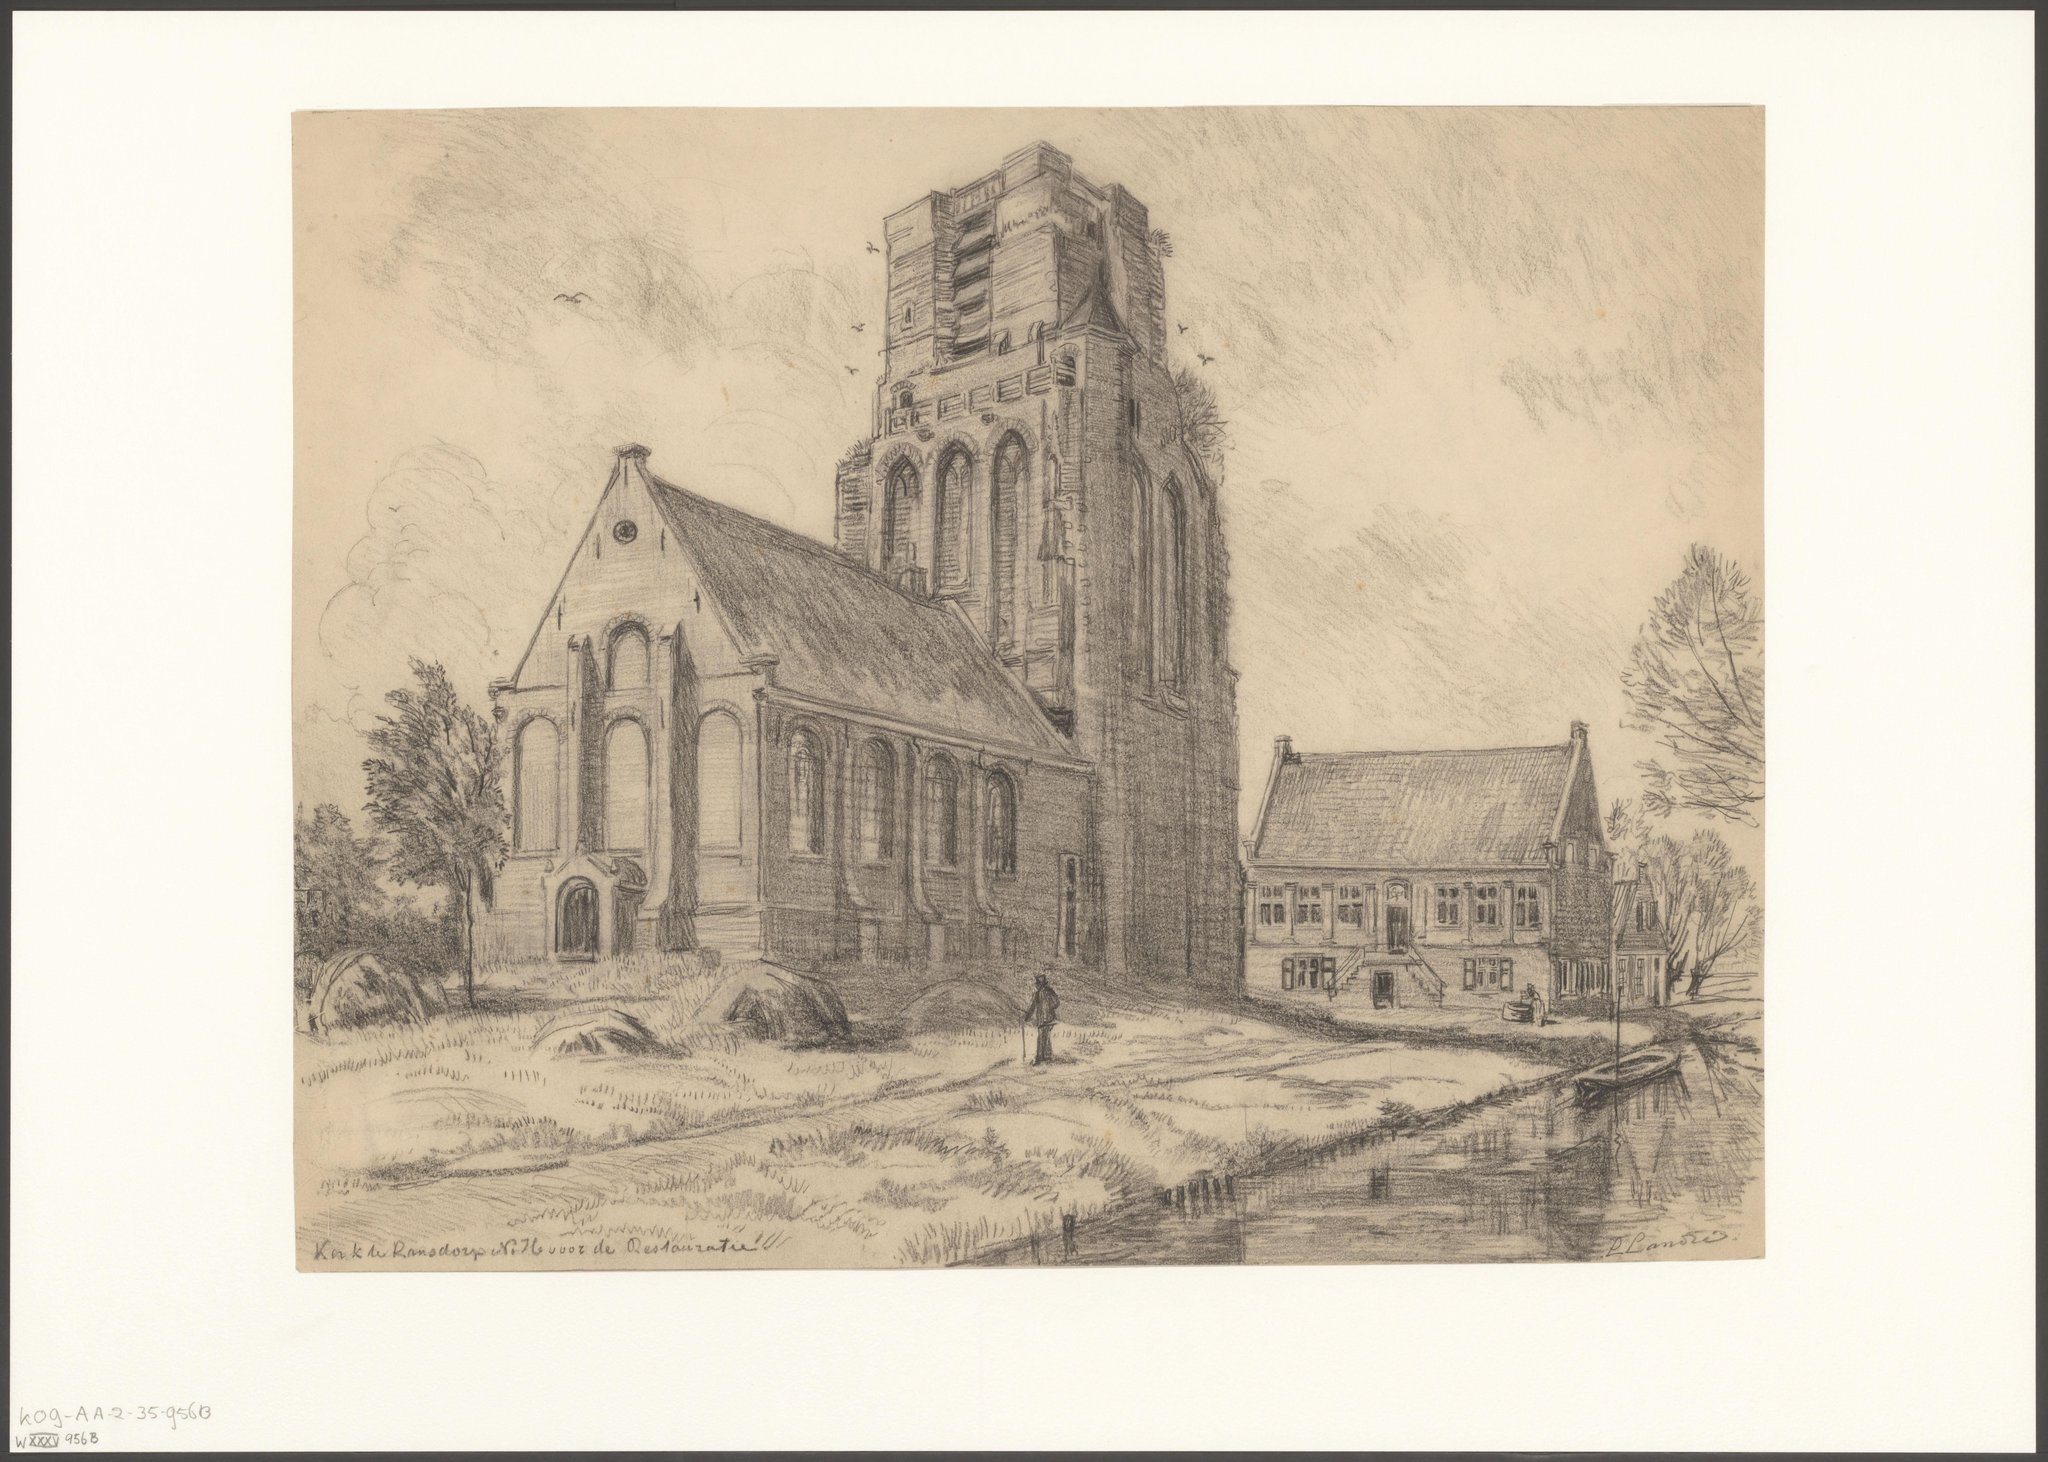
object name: drawing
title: Gezicht op de Kerk van Ransdorp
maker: Anonymous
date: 1900-1936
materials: chalk, paper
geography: amsterdam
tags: village, church (exterior)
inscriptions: inscription: ‘L 781 / Ransdorp’, inscription: ‘Kerk te Ransdorp N.H. voor de Restauratie’, signature: ‘LLand[...]’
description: Tekening binnen de Atlas Van Eck ingedeeld op wijknummer 35.